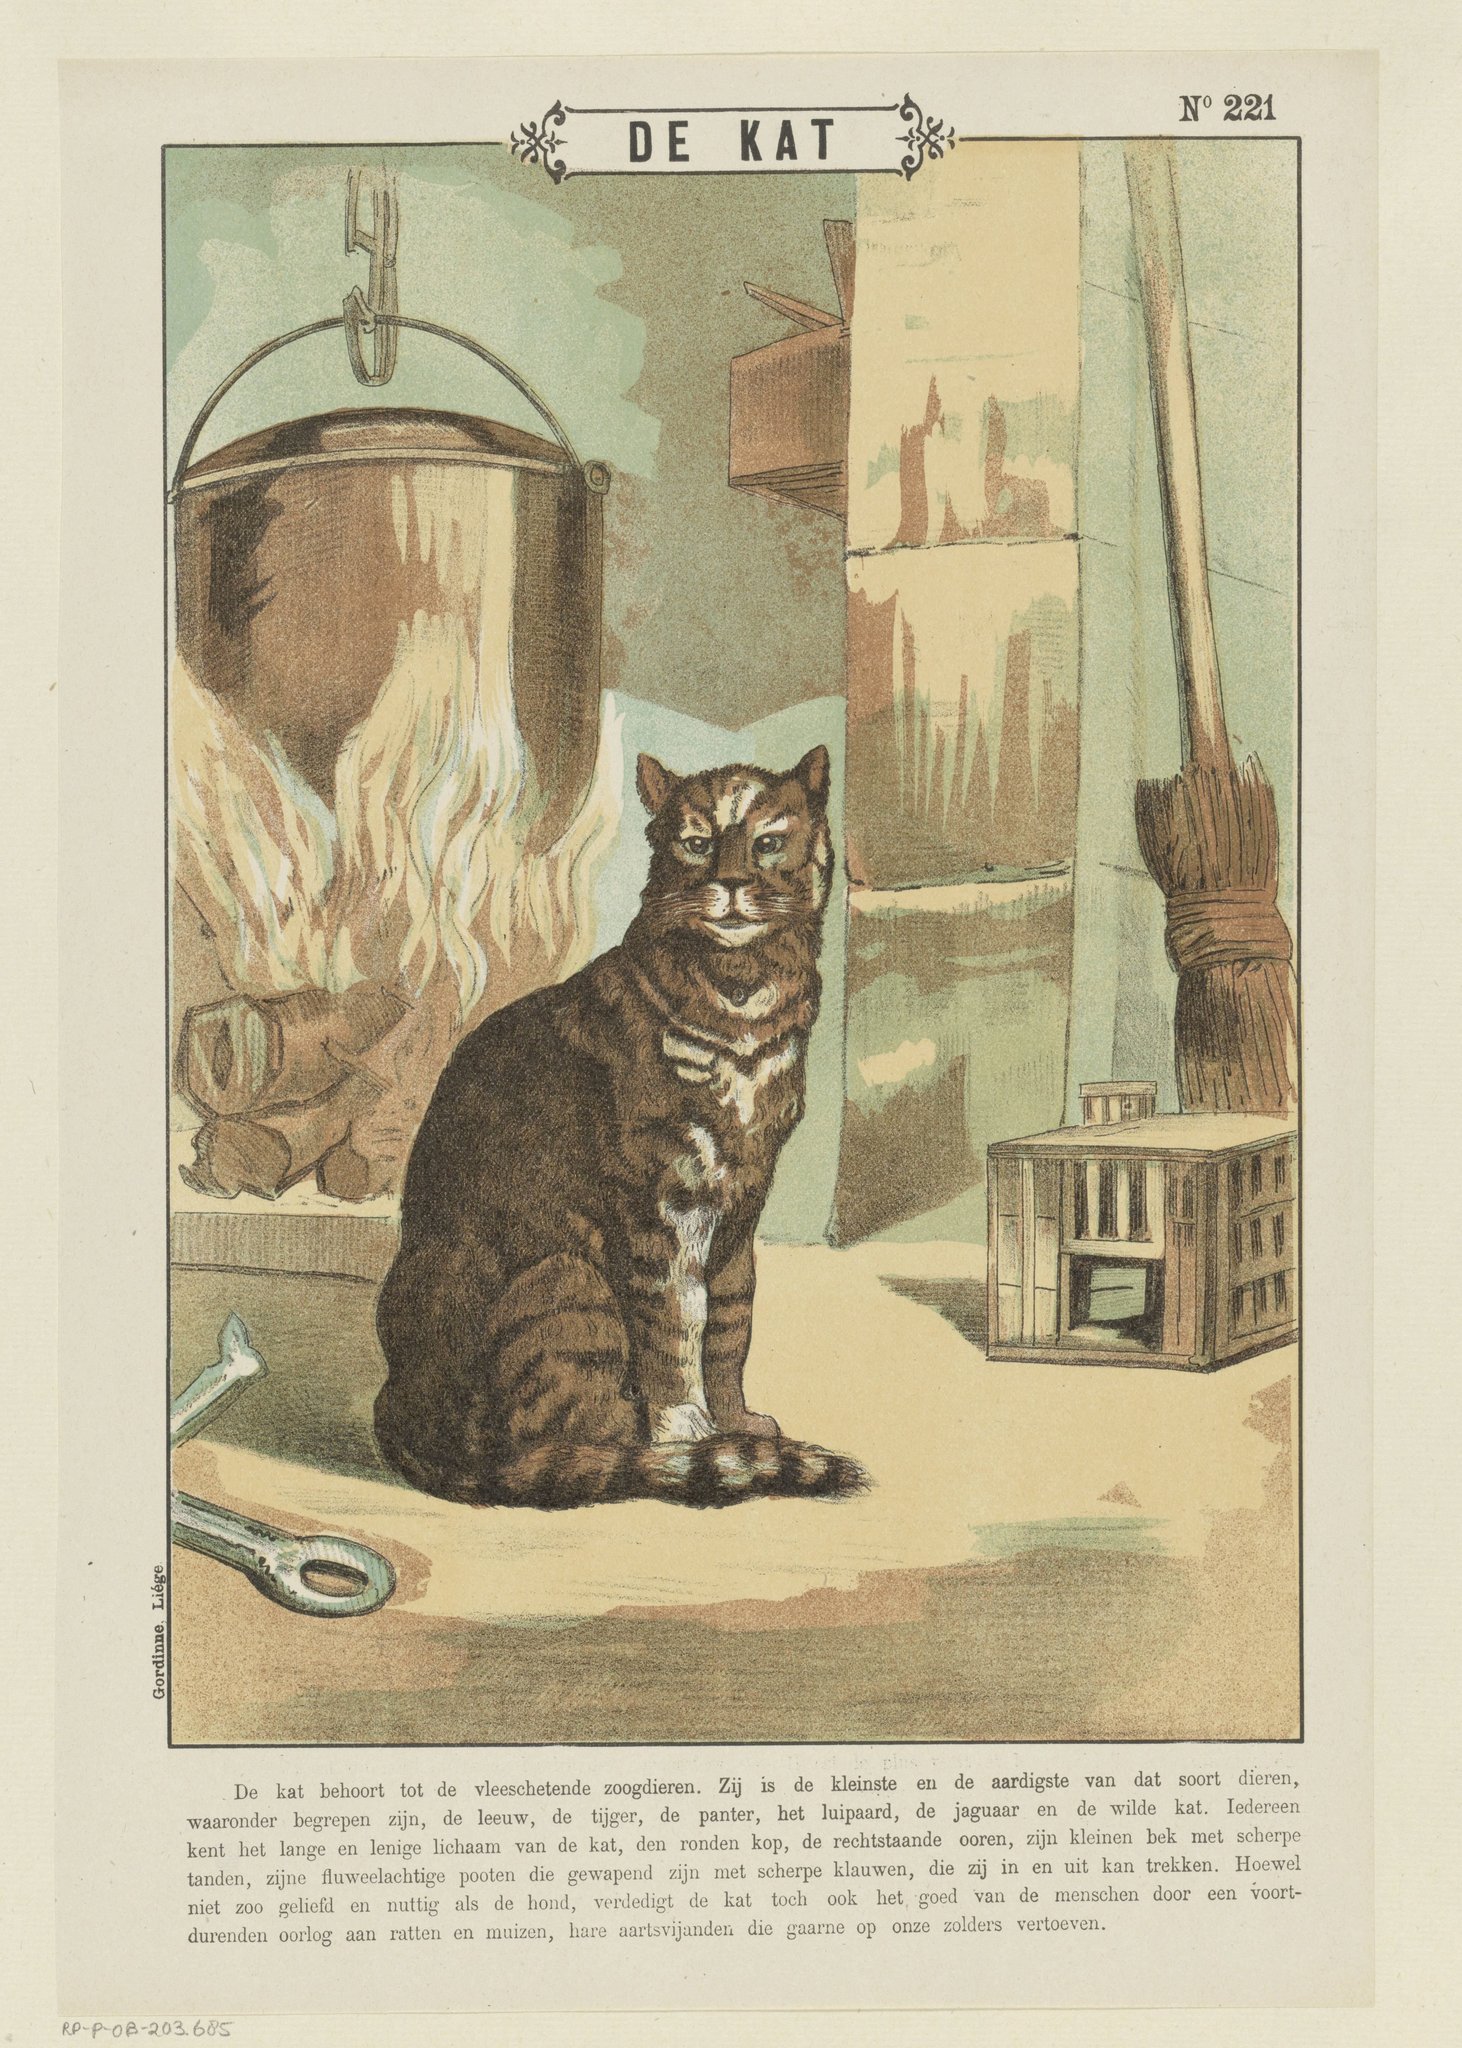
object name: popular print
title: De kat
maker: Anonymous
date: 1894-1959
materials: paper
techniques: lithograph, letterpress printing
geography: liège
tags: cat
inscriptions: collector's mark: Lugt 2760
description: Blad met een grote voorstelling van een kat in een keuken. In de ondermarge een onderschrift. Genummerd rechtsboven: No 221.